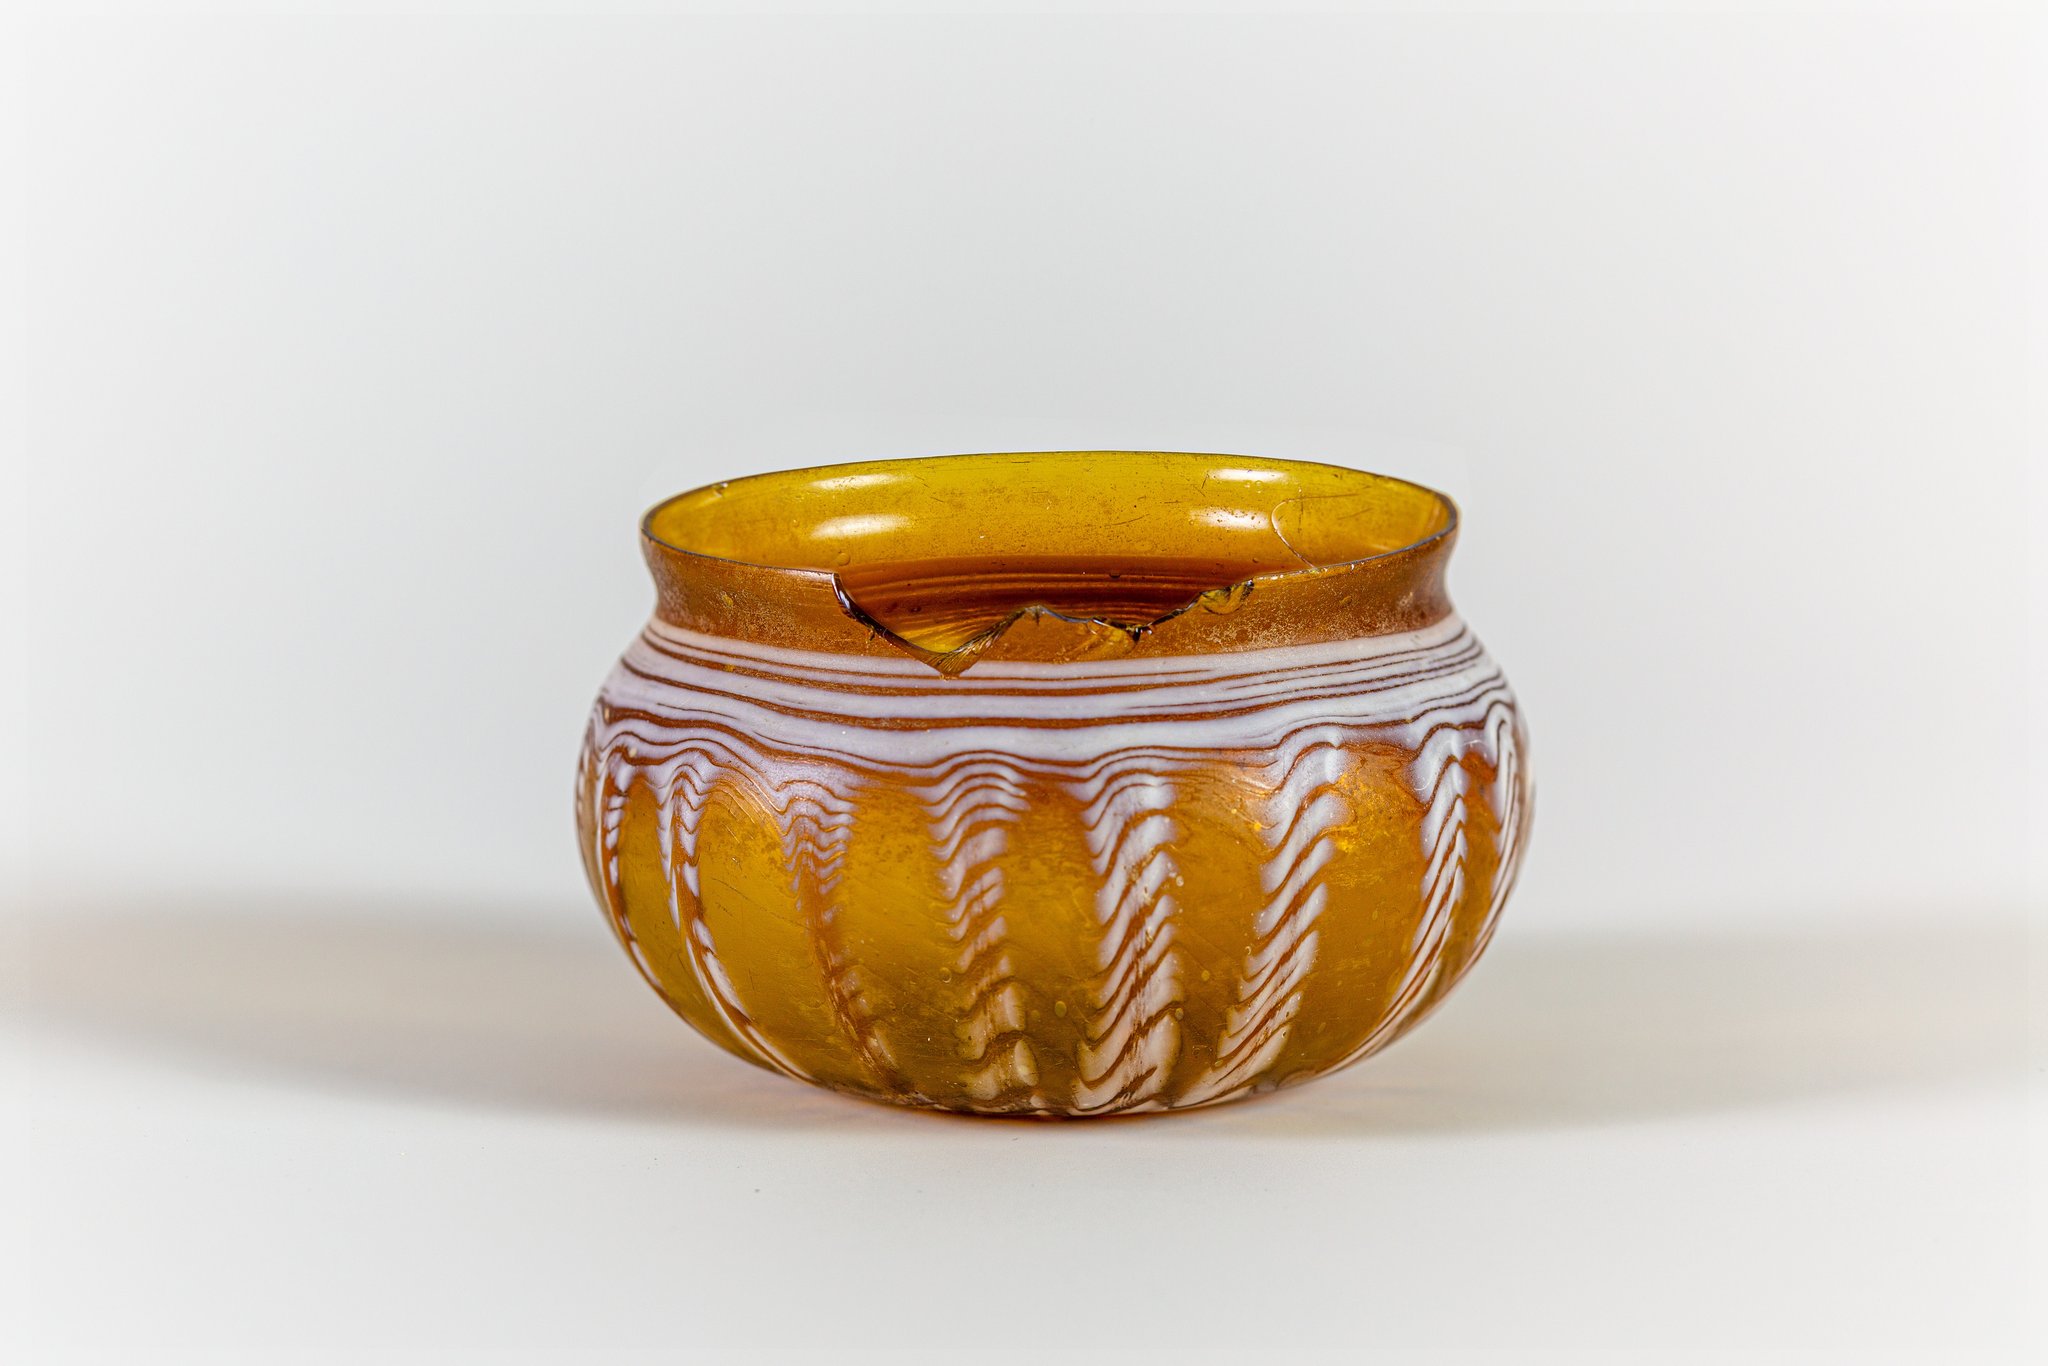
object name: bowl, rippenschale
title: Glass ribbed bowl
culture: roman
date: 34-66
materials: glass